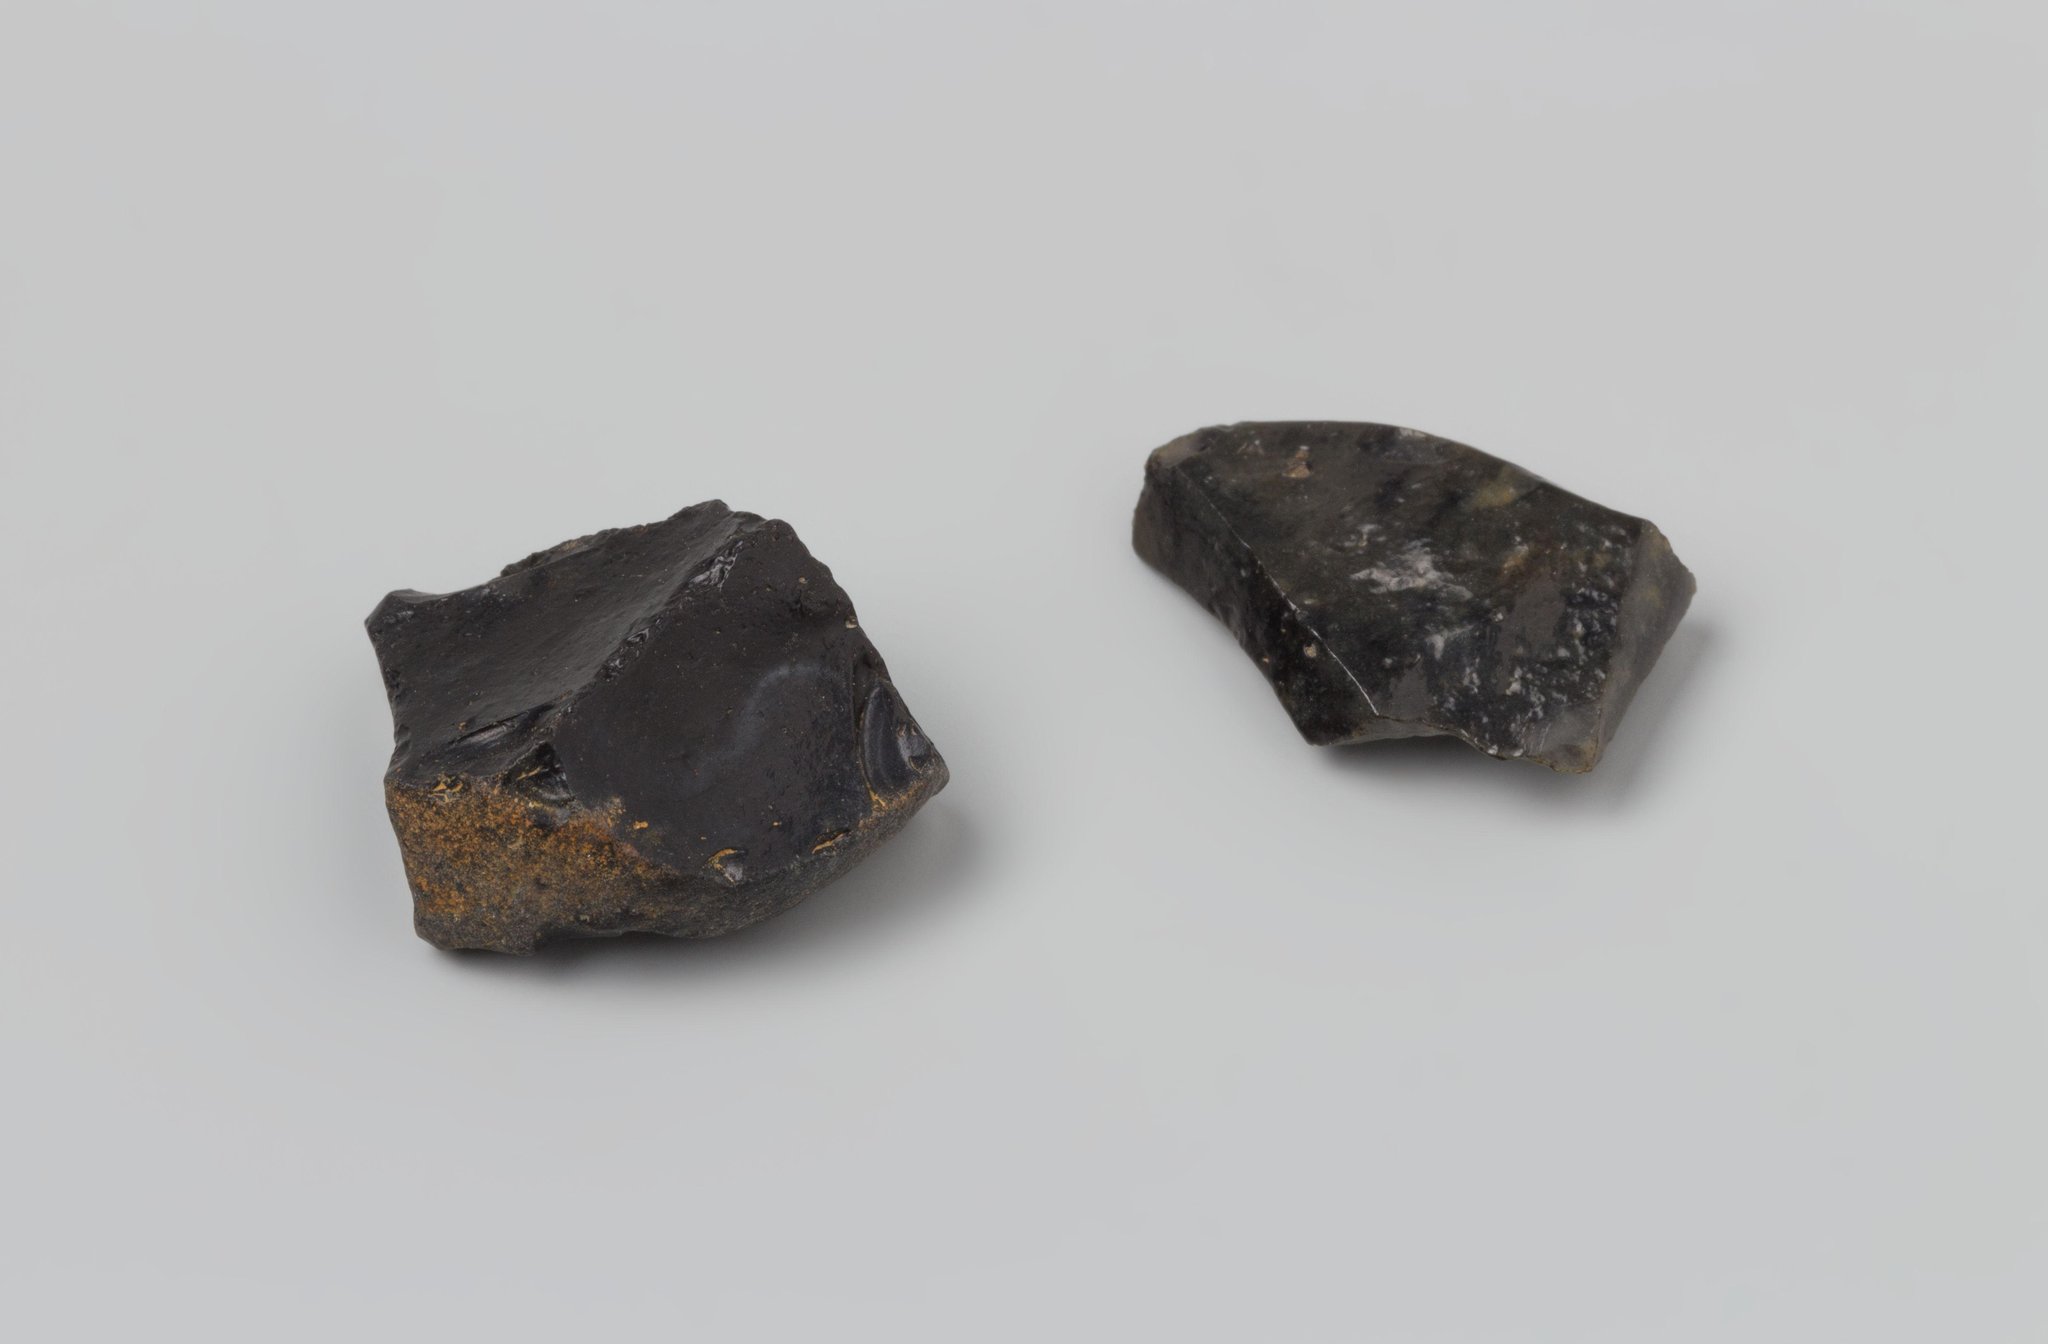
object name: flint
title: Vuursteen uit het wrak van de Oost-Indiëvaarder 't Vliegend Hart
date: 1730-1735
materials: stone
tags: 't vliegend hart (schip), verenigde oostindische compagnie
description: Vuursteen, van buiten wittig, waar de steen is gespleten glanzend zwart. Twee stuks. Flint.